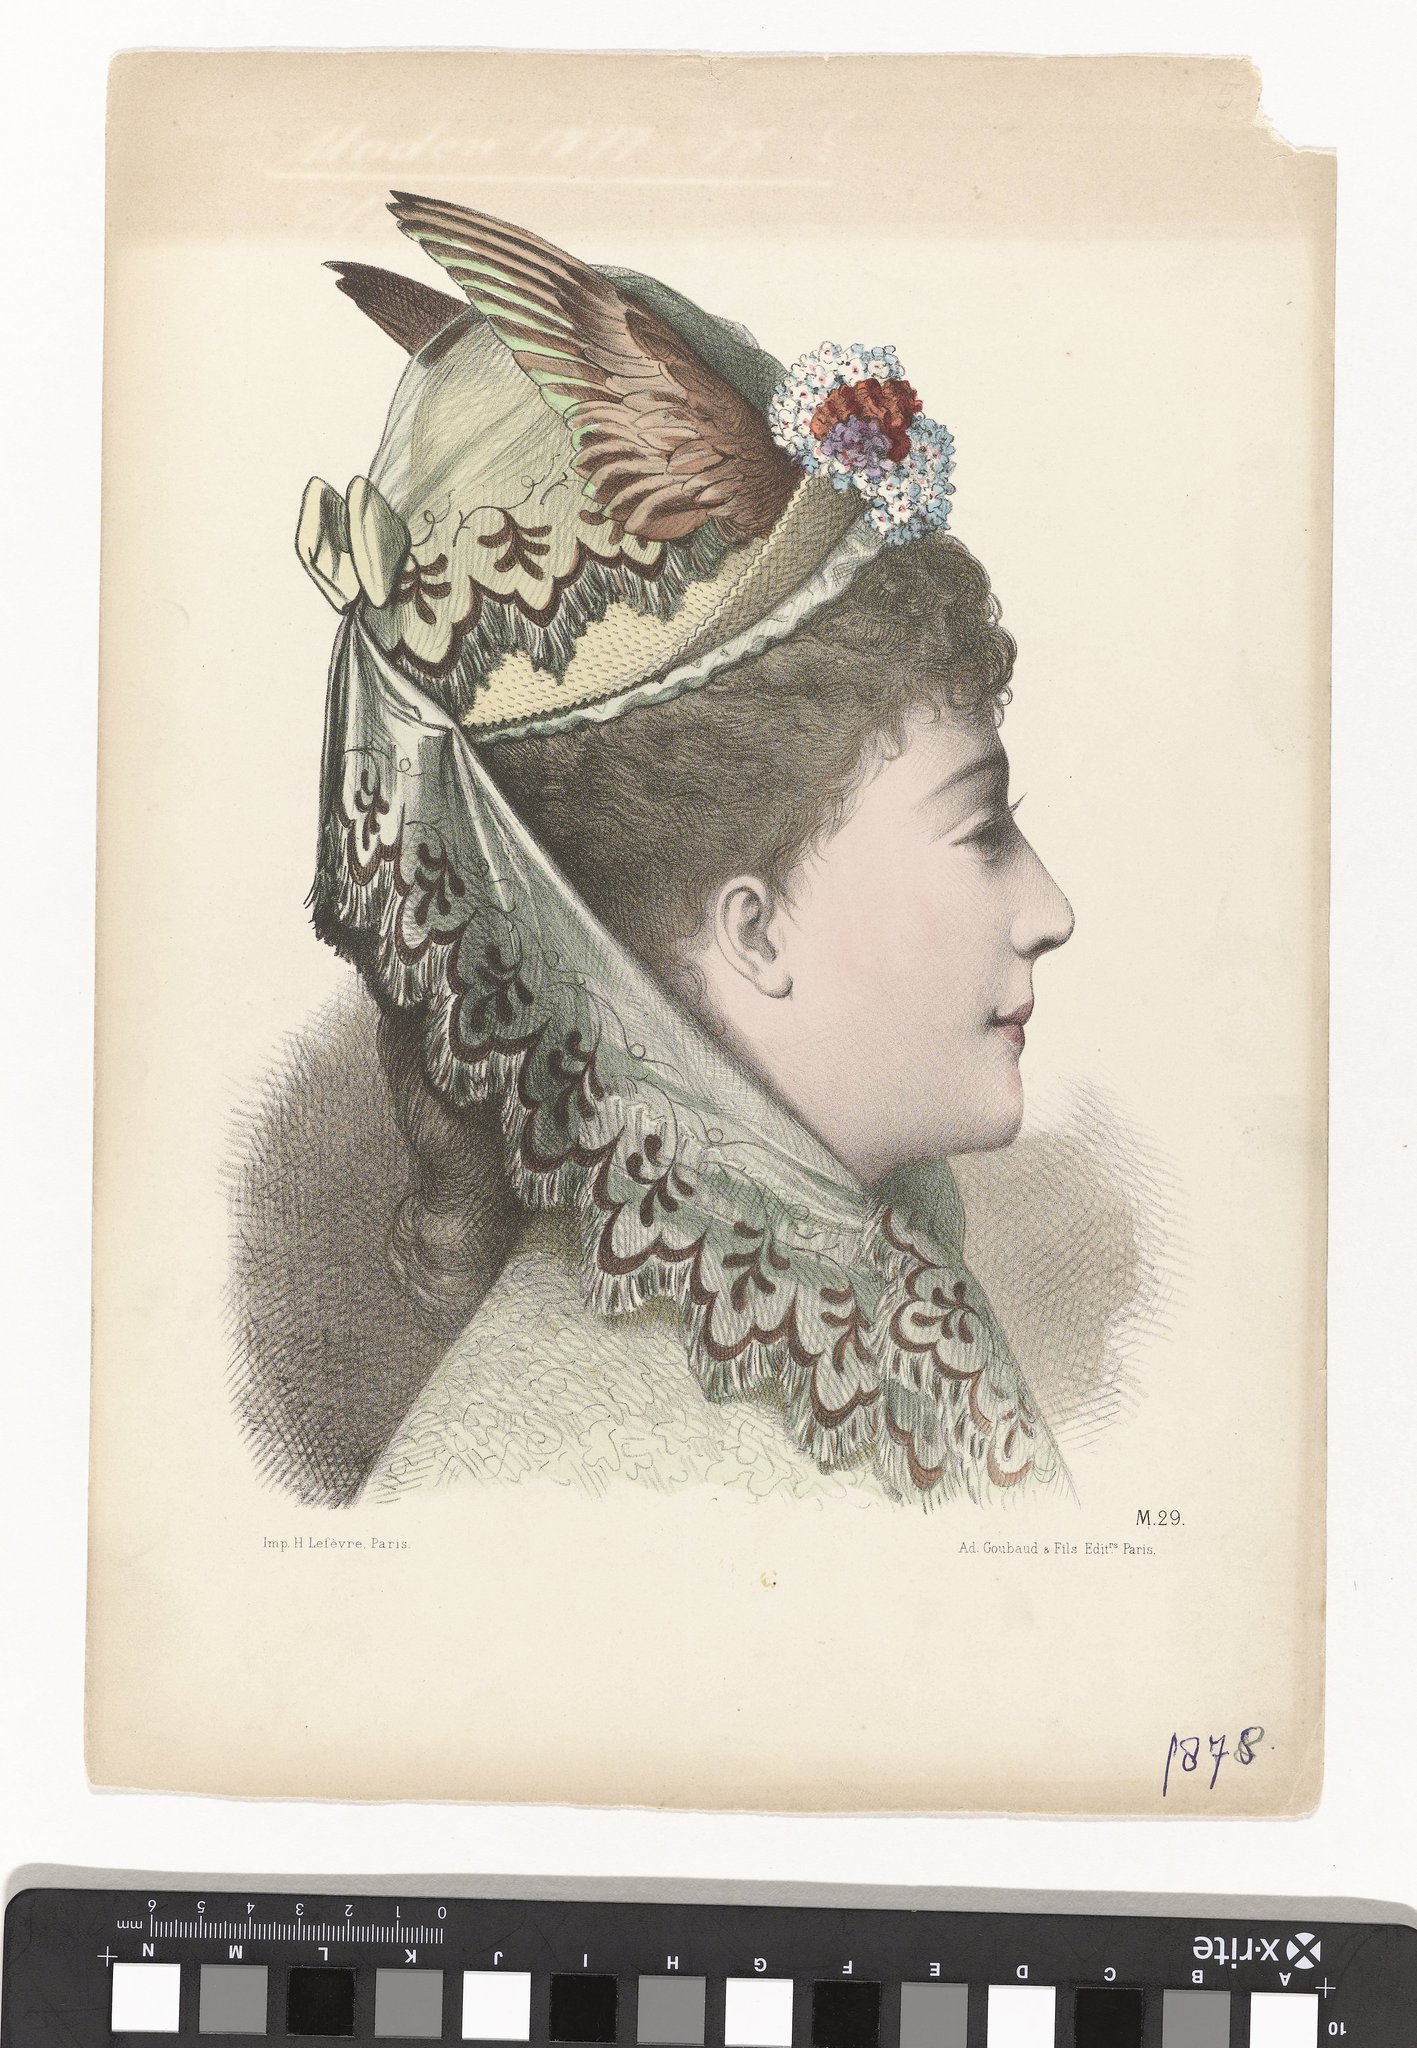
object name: fashion print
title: Vrouwenhoofd met hoed en voile, 1875, No. M.29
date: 1875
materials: paper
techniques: hand coloring, lithograph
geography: paris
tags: flowers, veil (+ women's clothes), border, ribbon, braid (+ women's clothes), head turned to the right - aa - female human figure, fashion plates, head-gear: hat (+ women's clothes), head-gear: hat (+ feathers used for clothes)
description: Vrouwenhoofd, en profil naar rechts, met een hoed overtrokken met een voile met geschulpte zoom en franjes, die onder de kin is vastgemaakt. De hoed is aan weerszijden versierd met veren of vleugels en middenvoor met bloemen.